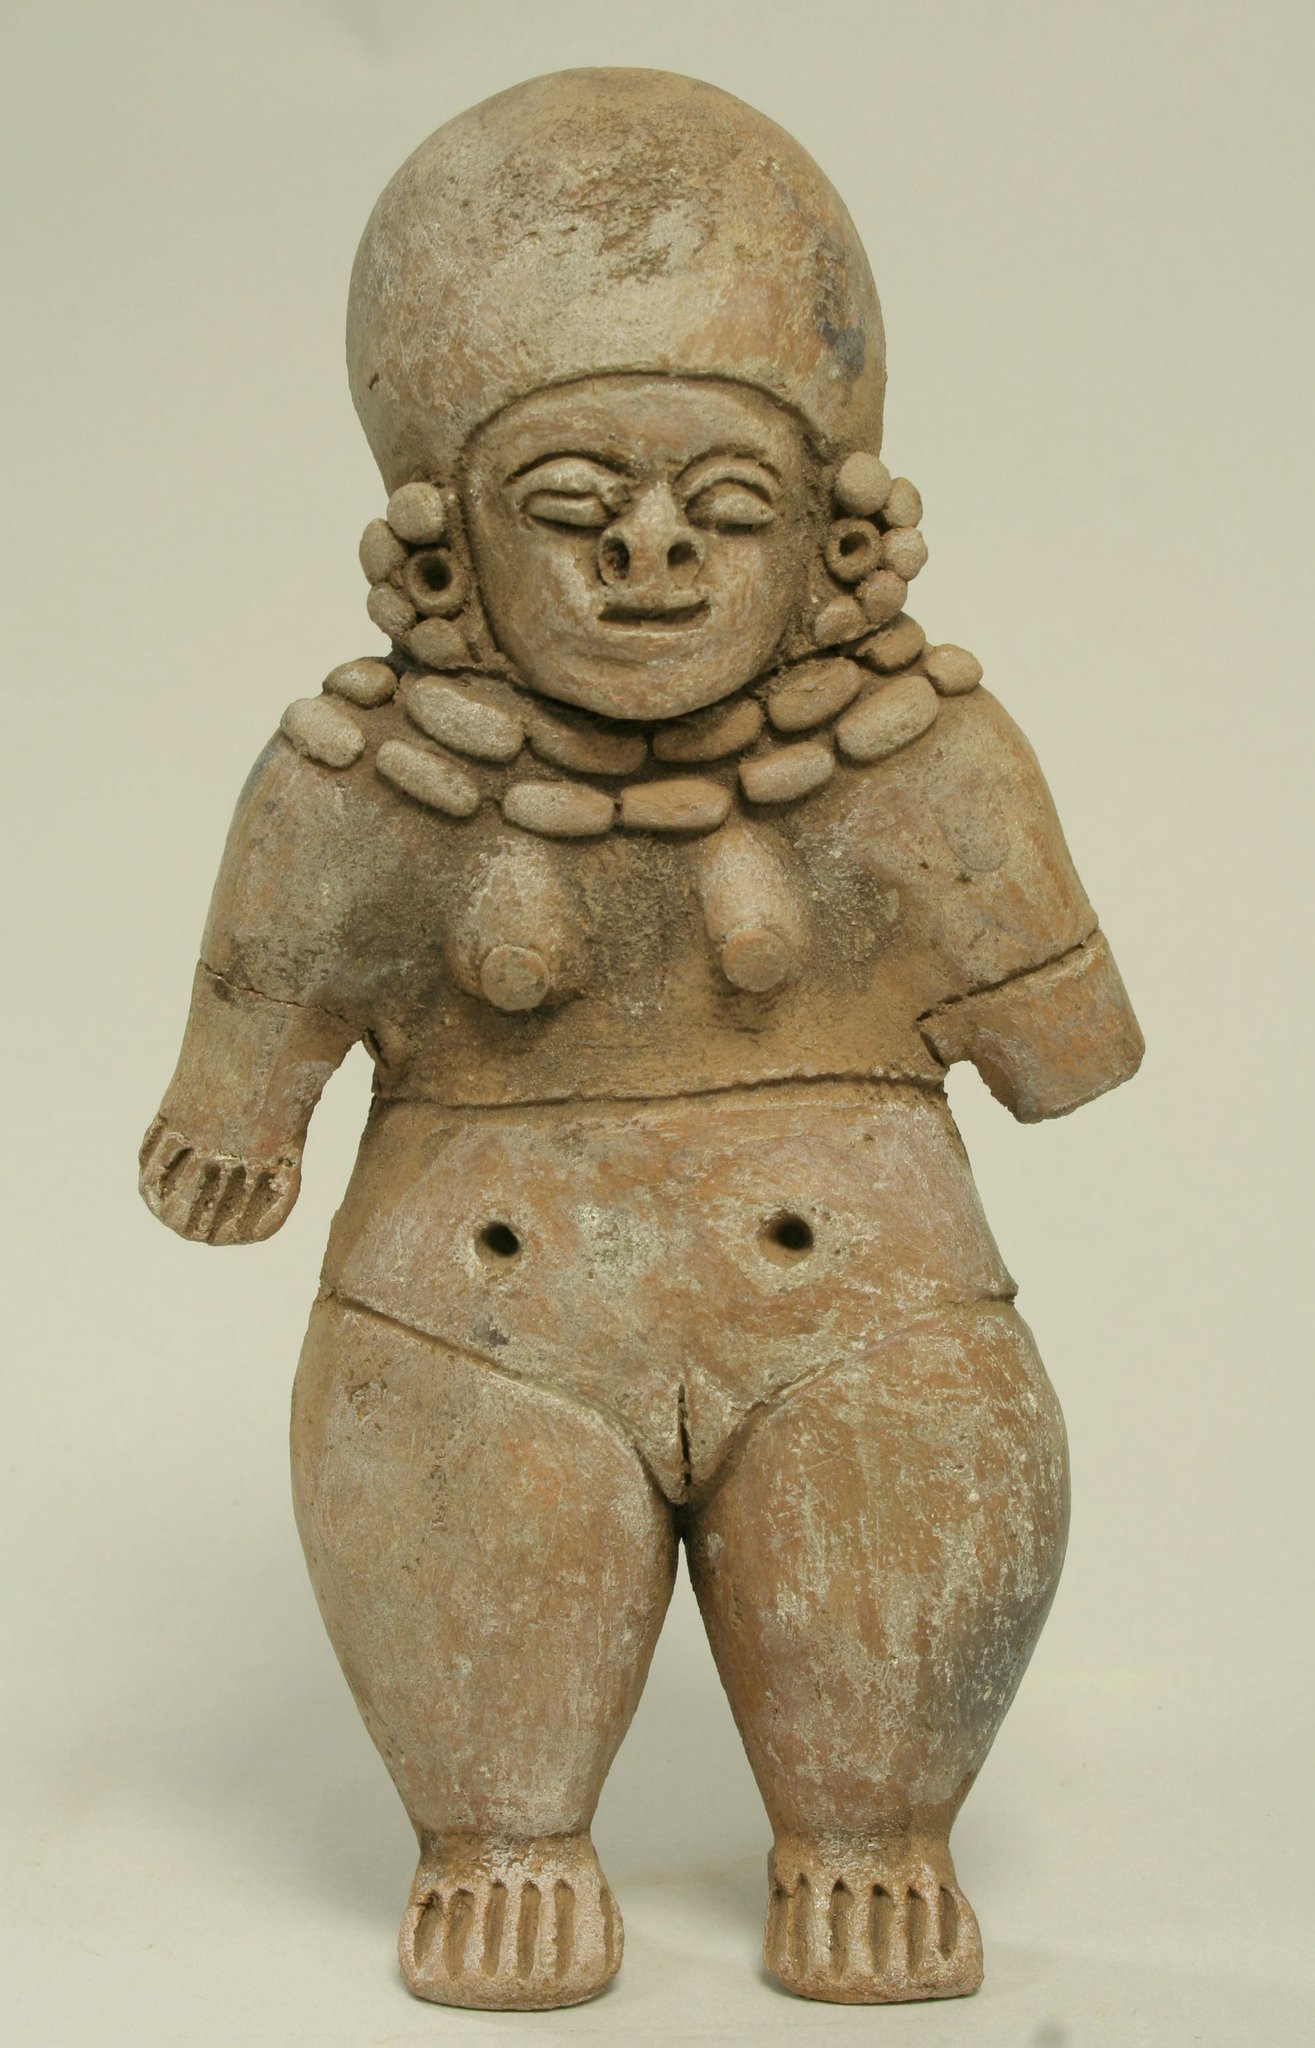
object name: female figure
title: Standing Ceramic Female Figure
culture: bahian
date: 500 BCE-400 CE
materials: ceramic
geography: ecuador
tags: female nudes